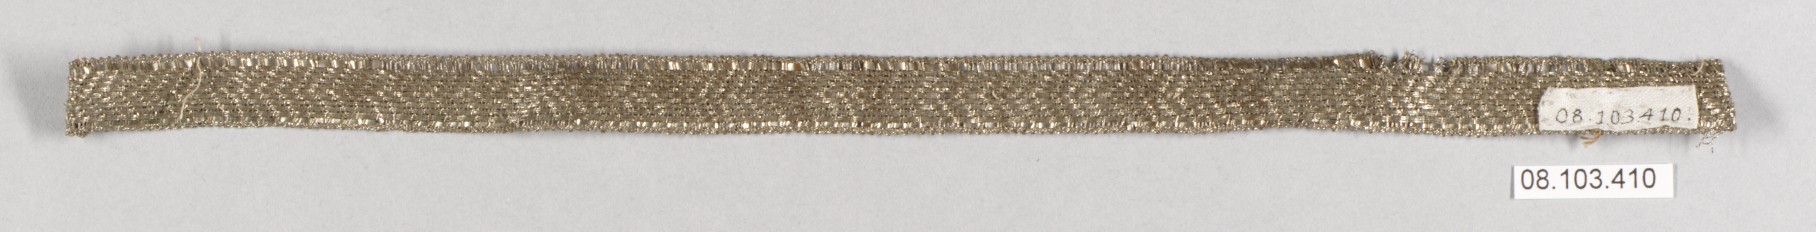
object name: galloon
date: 1601-1800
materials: metal thread